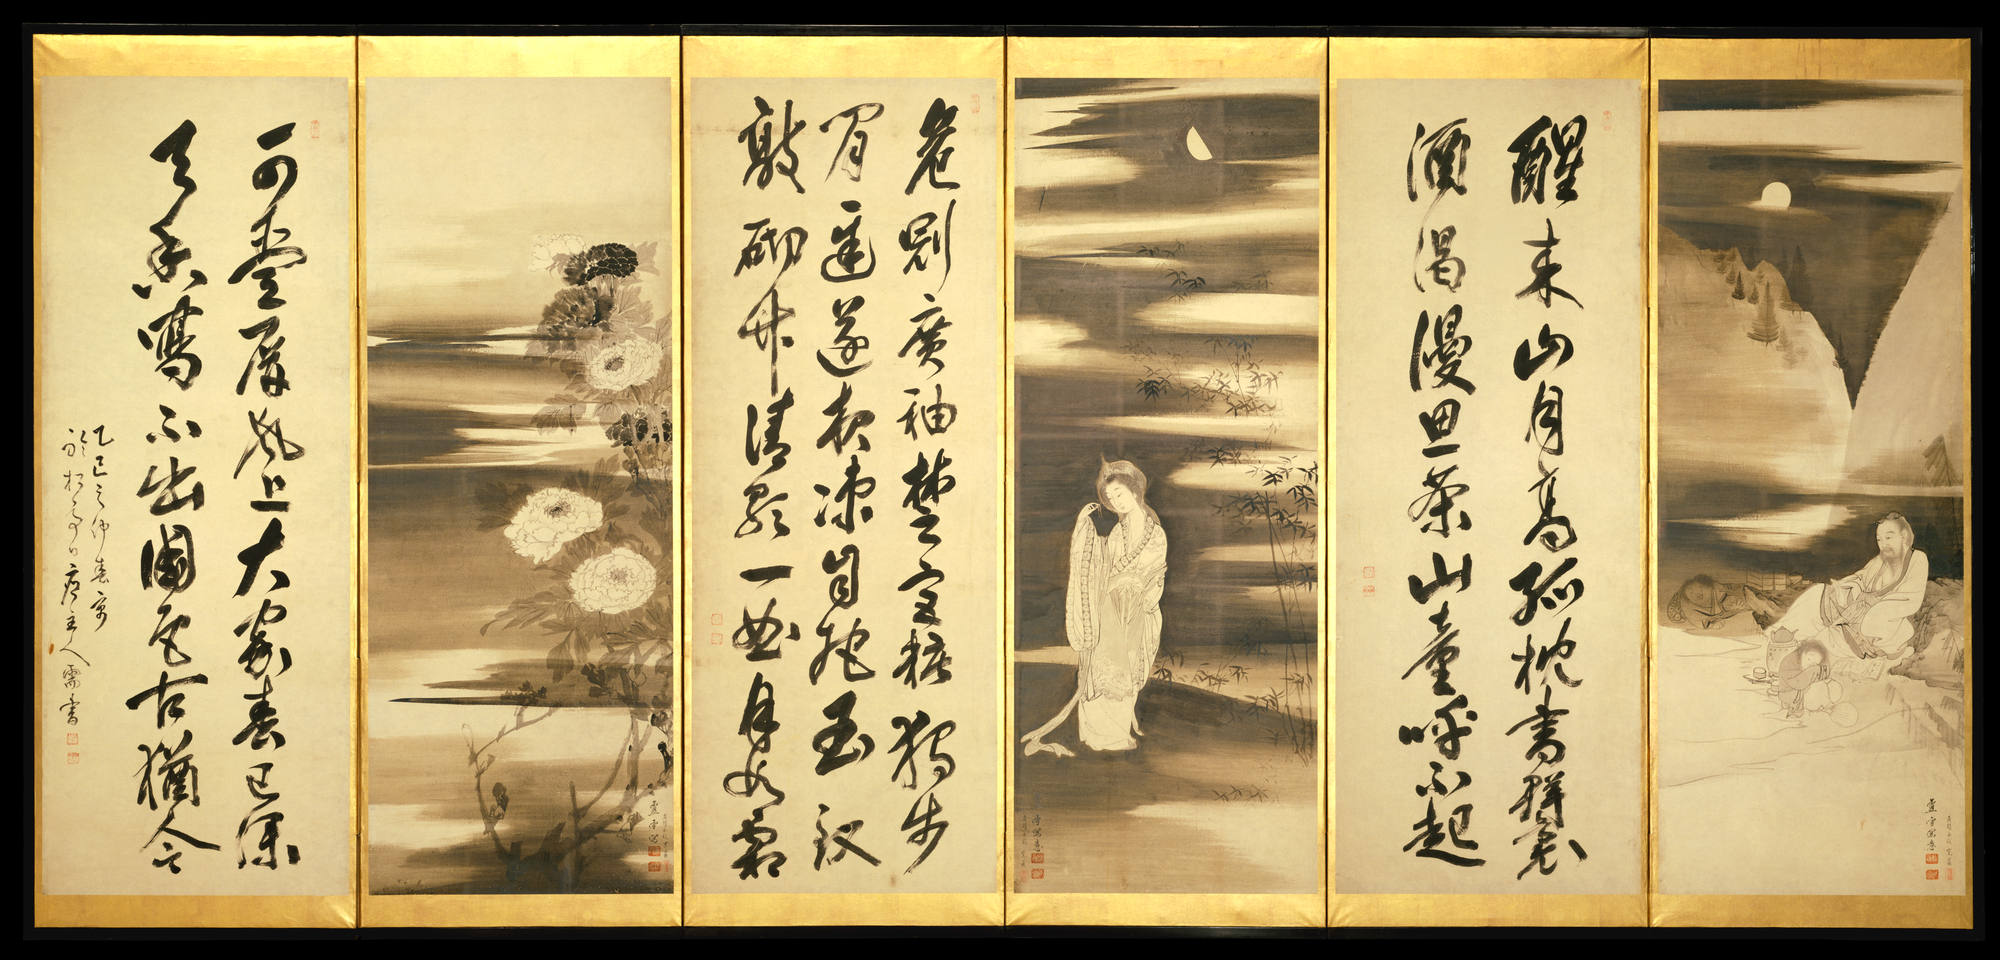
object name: screen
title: Miscellaneous Paintings and Calligraphy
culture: japanese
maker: nagasawa rosetsu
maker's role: artist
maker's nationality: japanese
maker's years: 1754-1799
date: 1785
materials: ink, panel, paper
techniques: calligraphy, painting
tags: men,women,flowers